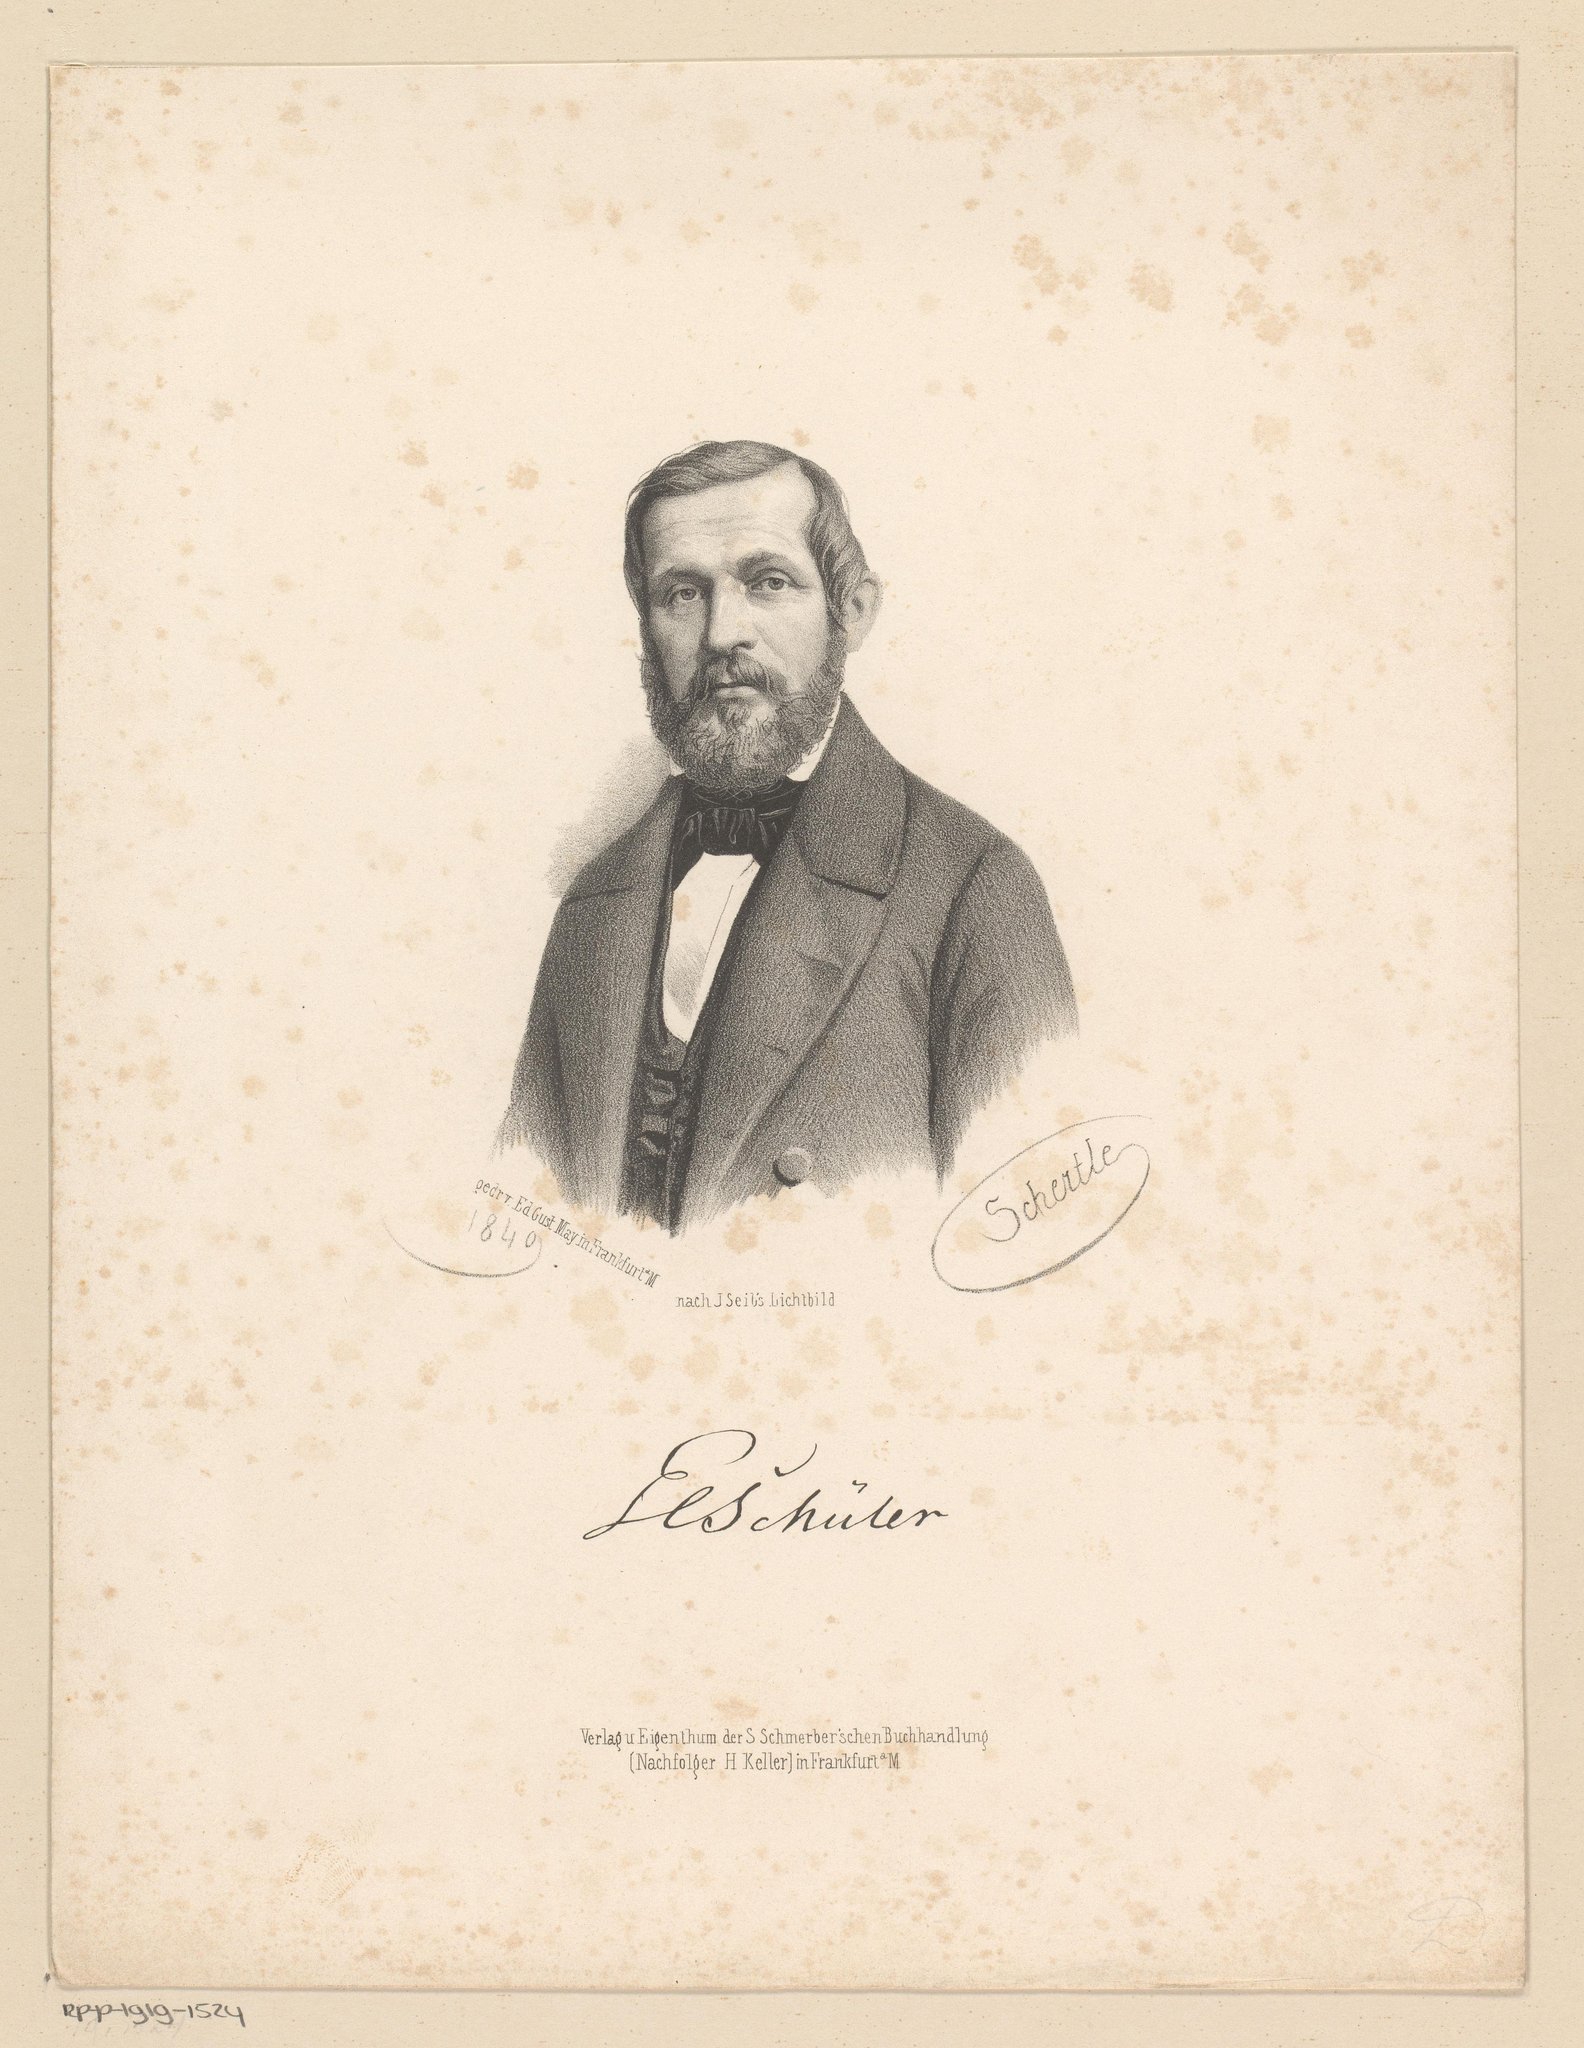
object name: print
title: Portretten van Duitse mannen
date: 1849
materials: paper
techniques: lithograph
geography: frankfurt am main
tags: politician, historical persons, politician, e.g. party leader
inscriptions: collector's mark: Lugt 2228